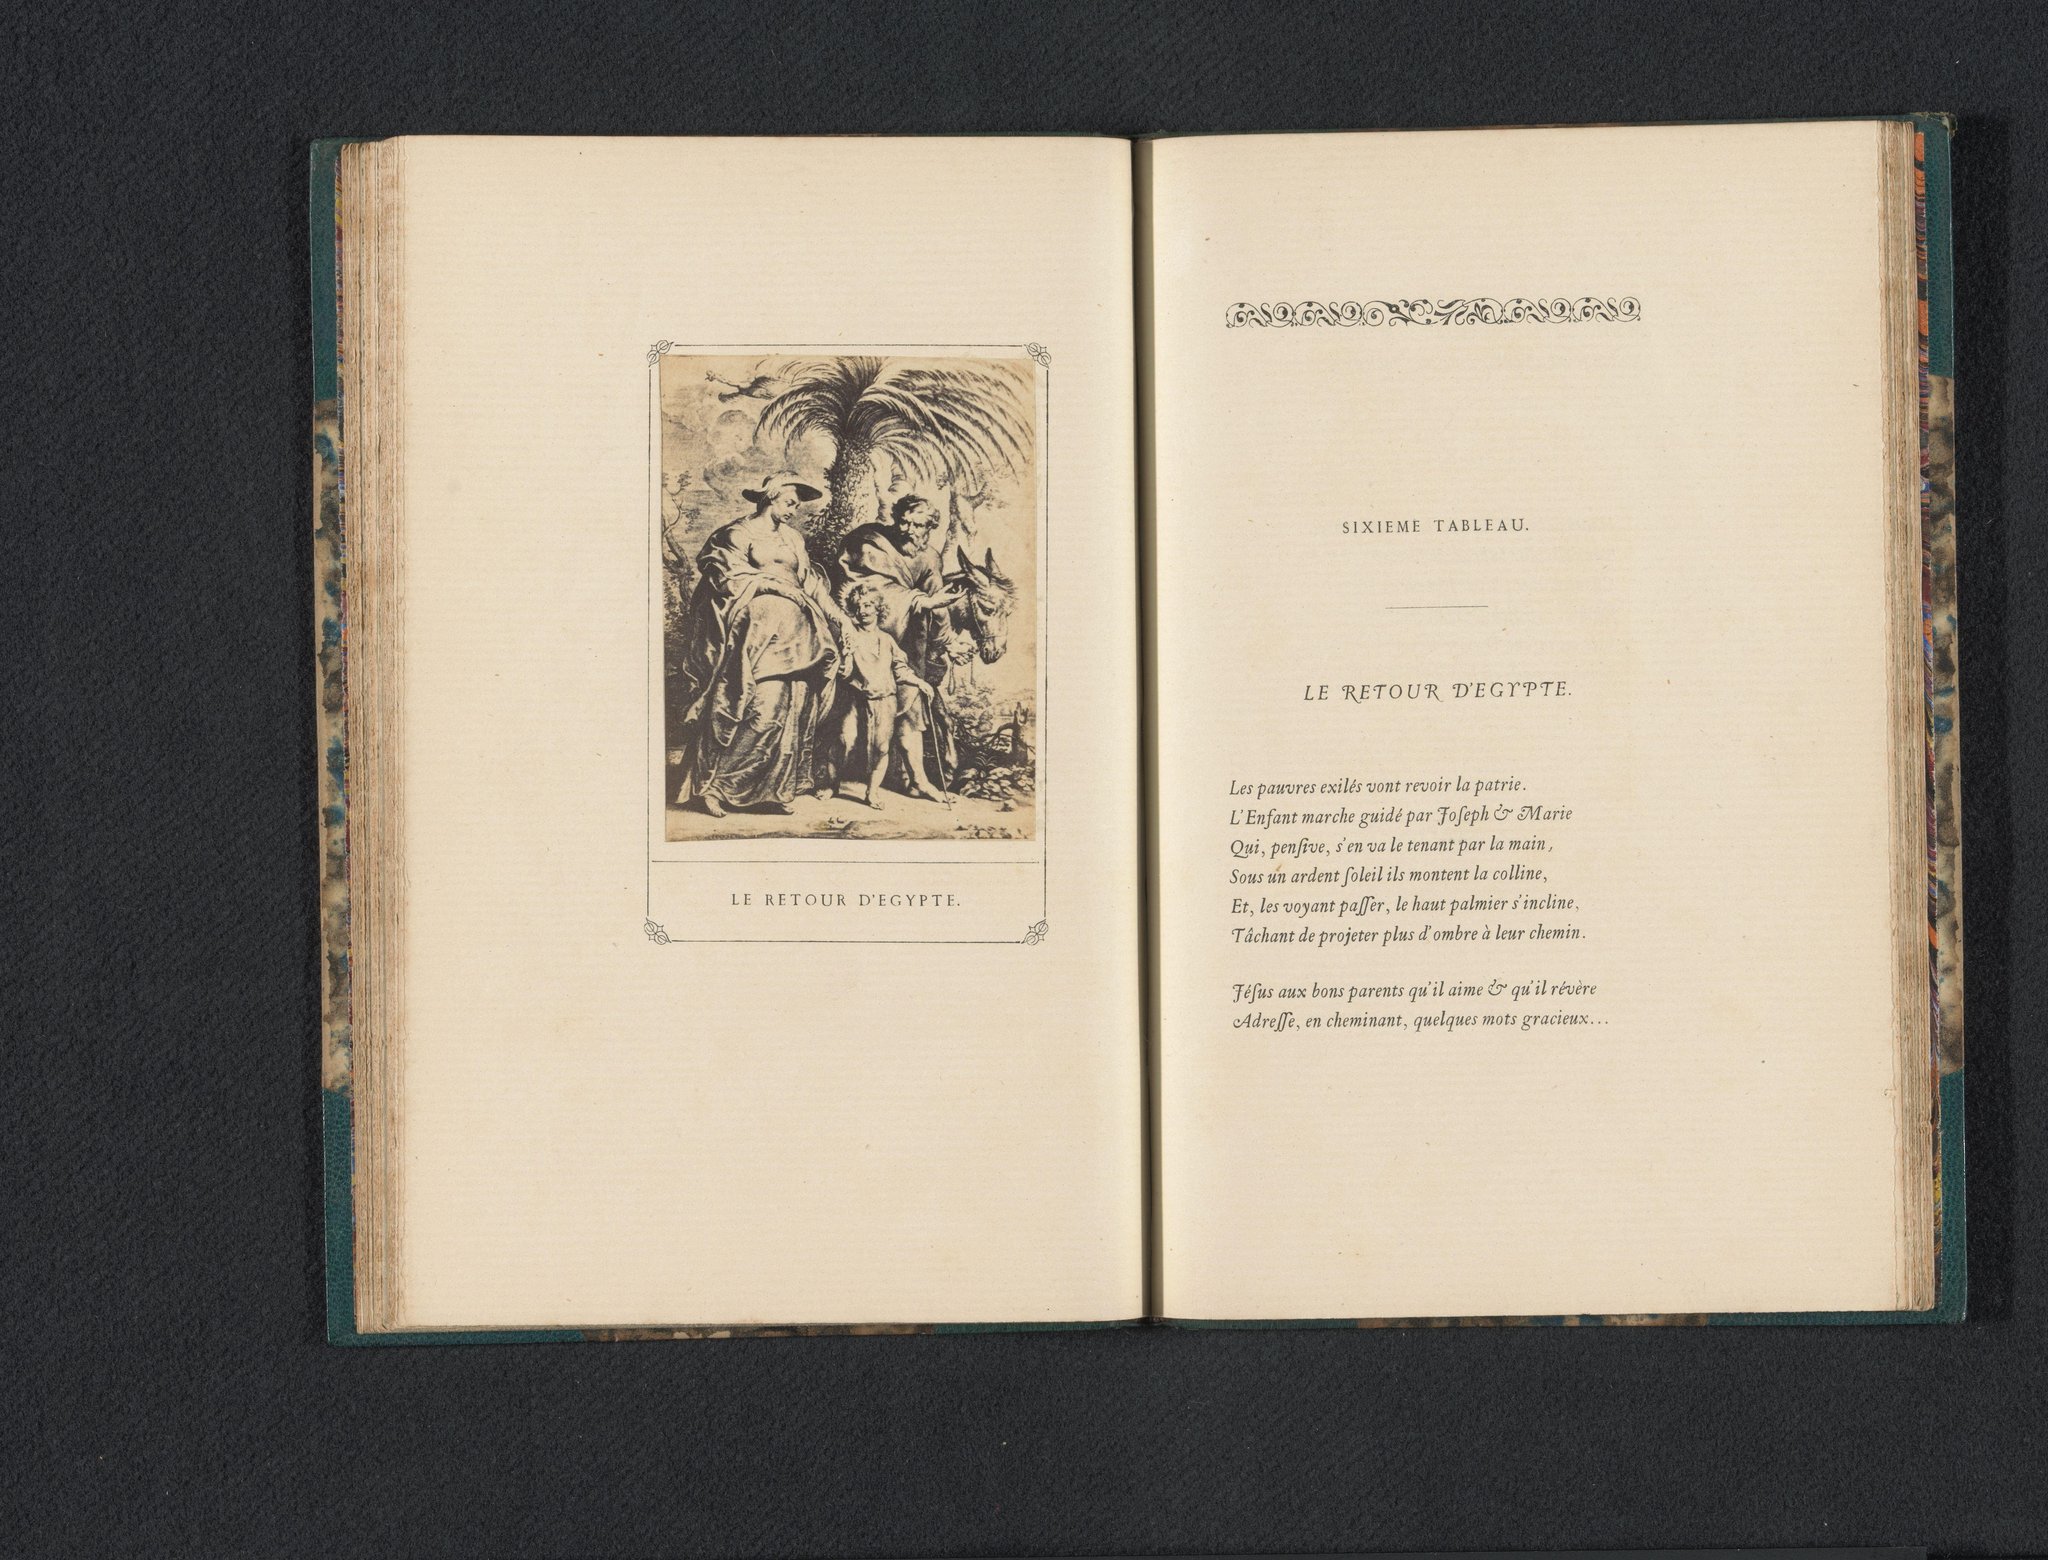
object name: page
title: Le retour d'Egypte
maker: edmond fierlants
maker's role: fotograaf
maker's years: 1819-1869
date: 1855-1860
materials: photographic support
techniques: albumen print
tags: flight into egypt and miracles during the journey